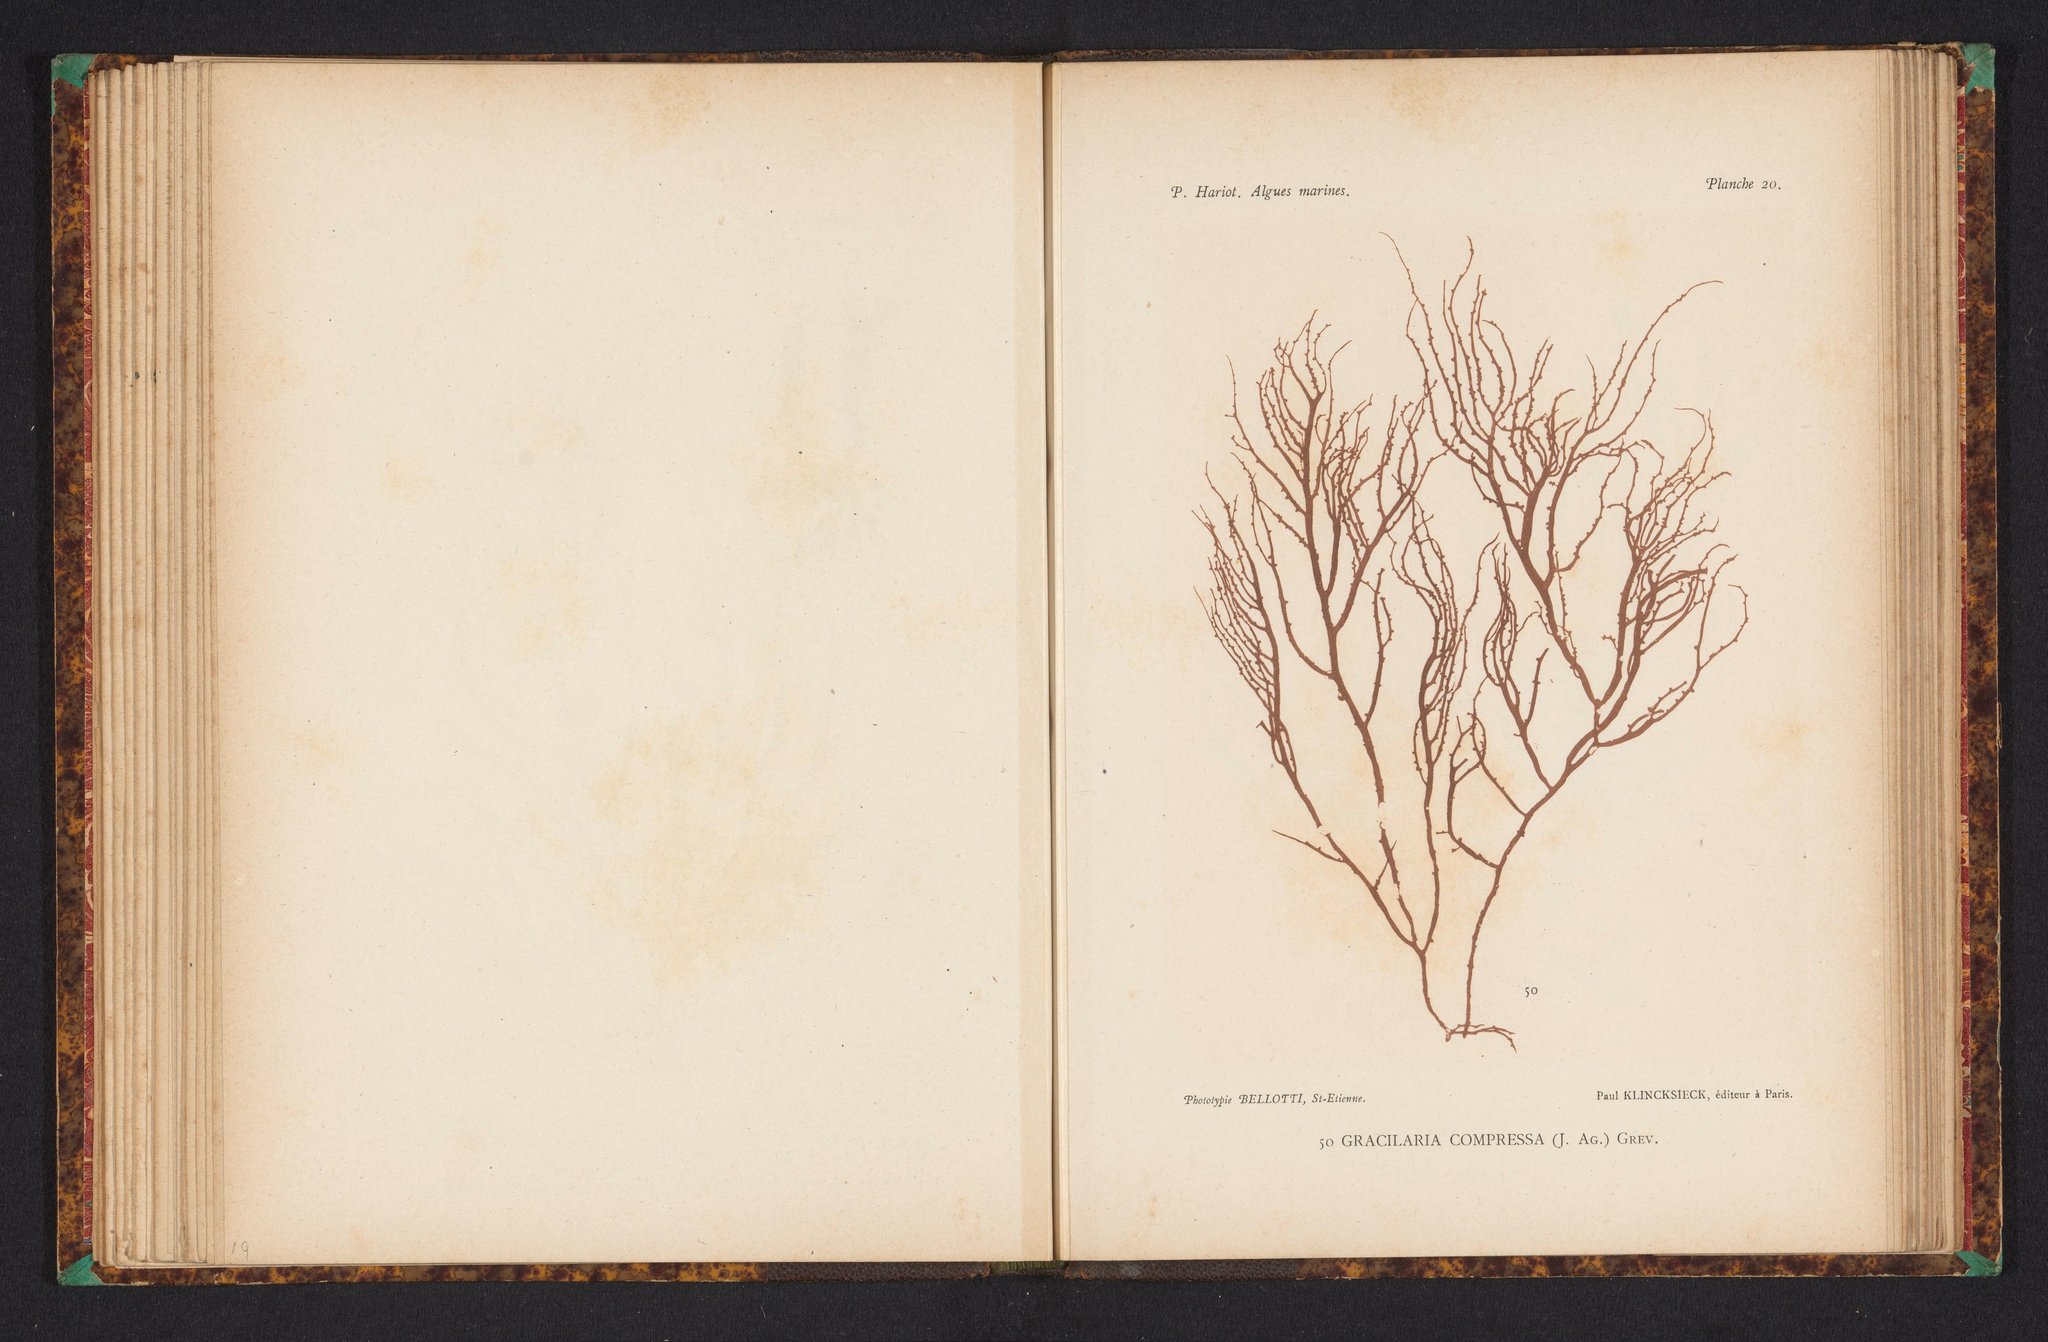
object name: page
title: Gracilaria compressa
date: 1882-1892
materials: paper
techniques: photograph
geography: saint-étienne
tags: algae, seaweed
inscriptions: number: ‘50’, inscription: ‘Gracilaria compressa’, number: ‘Planche 20.’